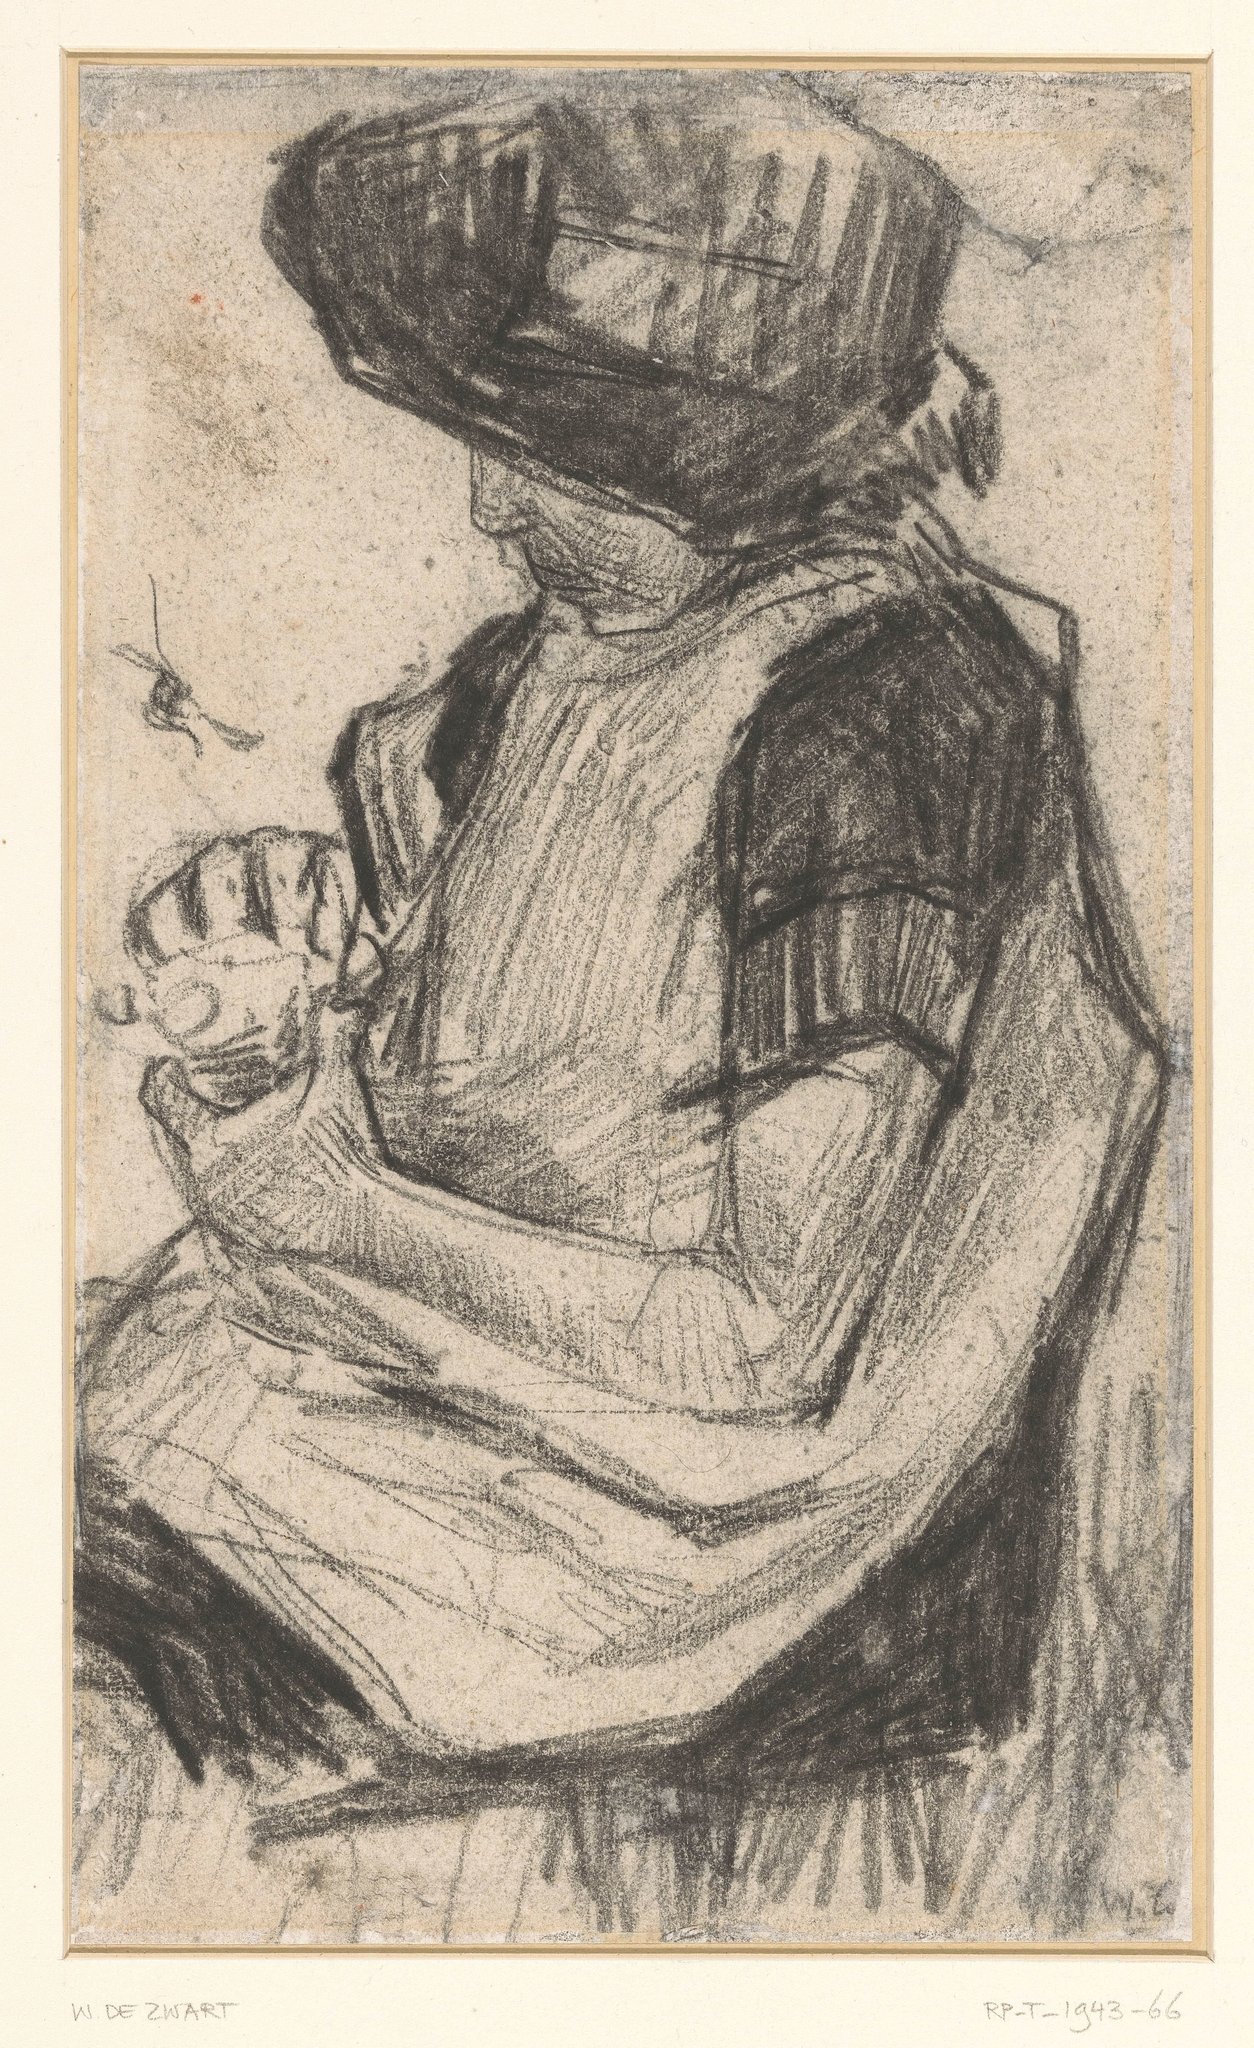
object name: drawing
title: Zittend meisje, naar links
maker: willem de zwart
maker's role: draughtsman, painter, print maker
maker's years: 1862-1931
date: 1872-1931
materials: chalk, paper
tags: sitting figure - aa - female human figure, girl (child between toddler and youth)